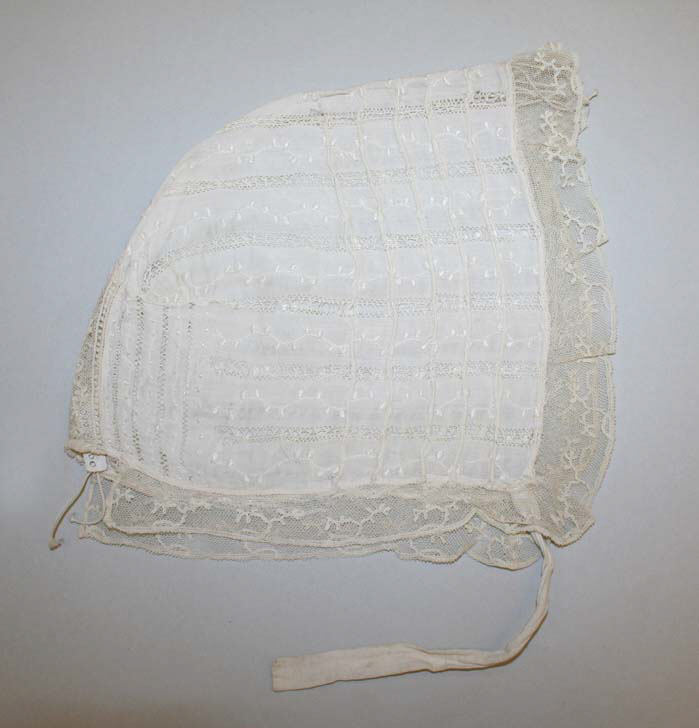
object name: cap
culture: british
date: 1801-1900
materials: linen